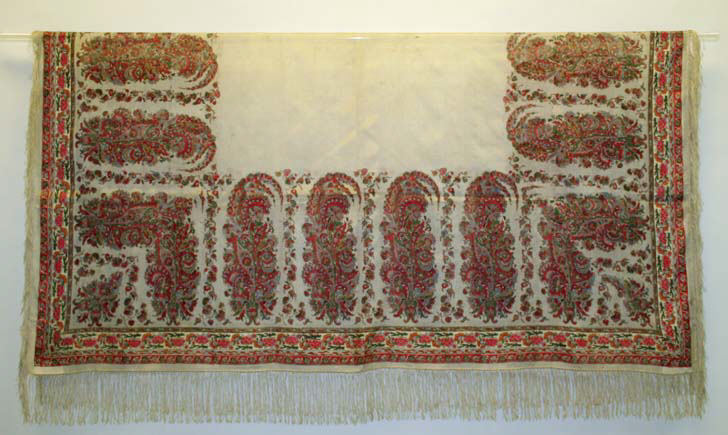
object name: shawl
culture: british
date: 1845-1850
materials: silk